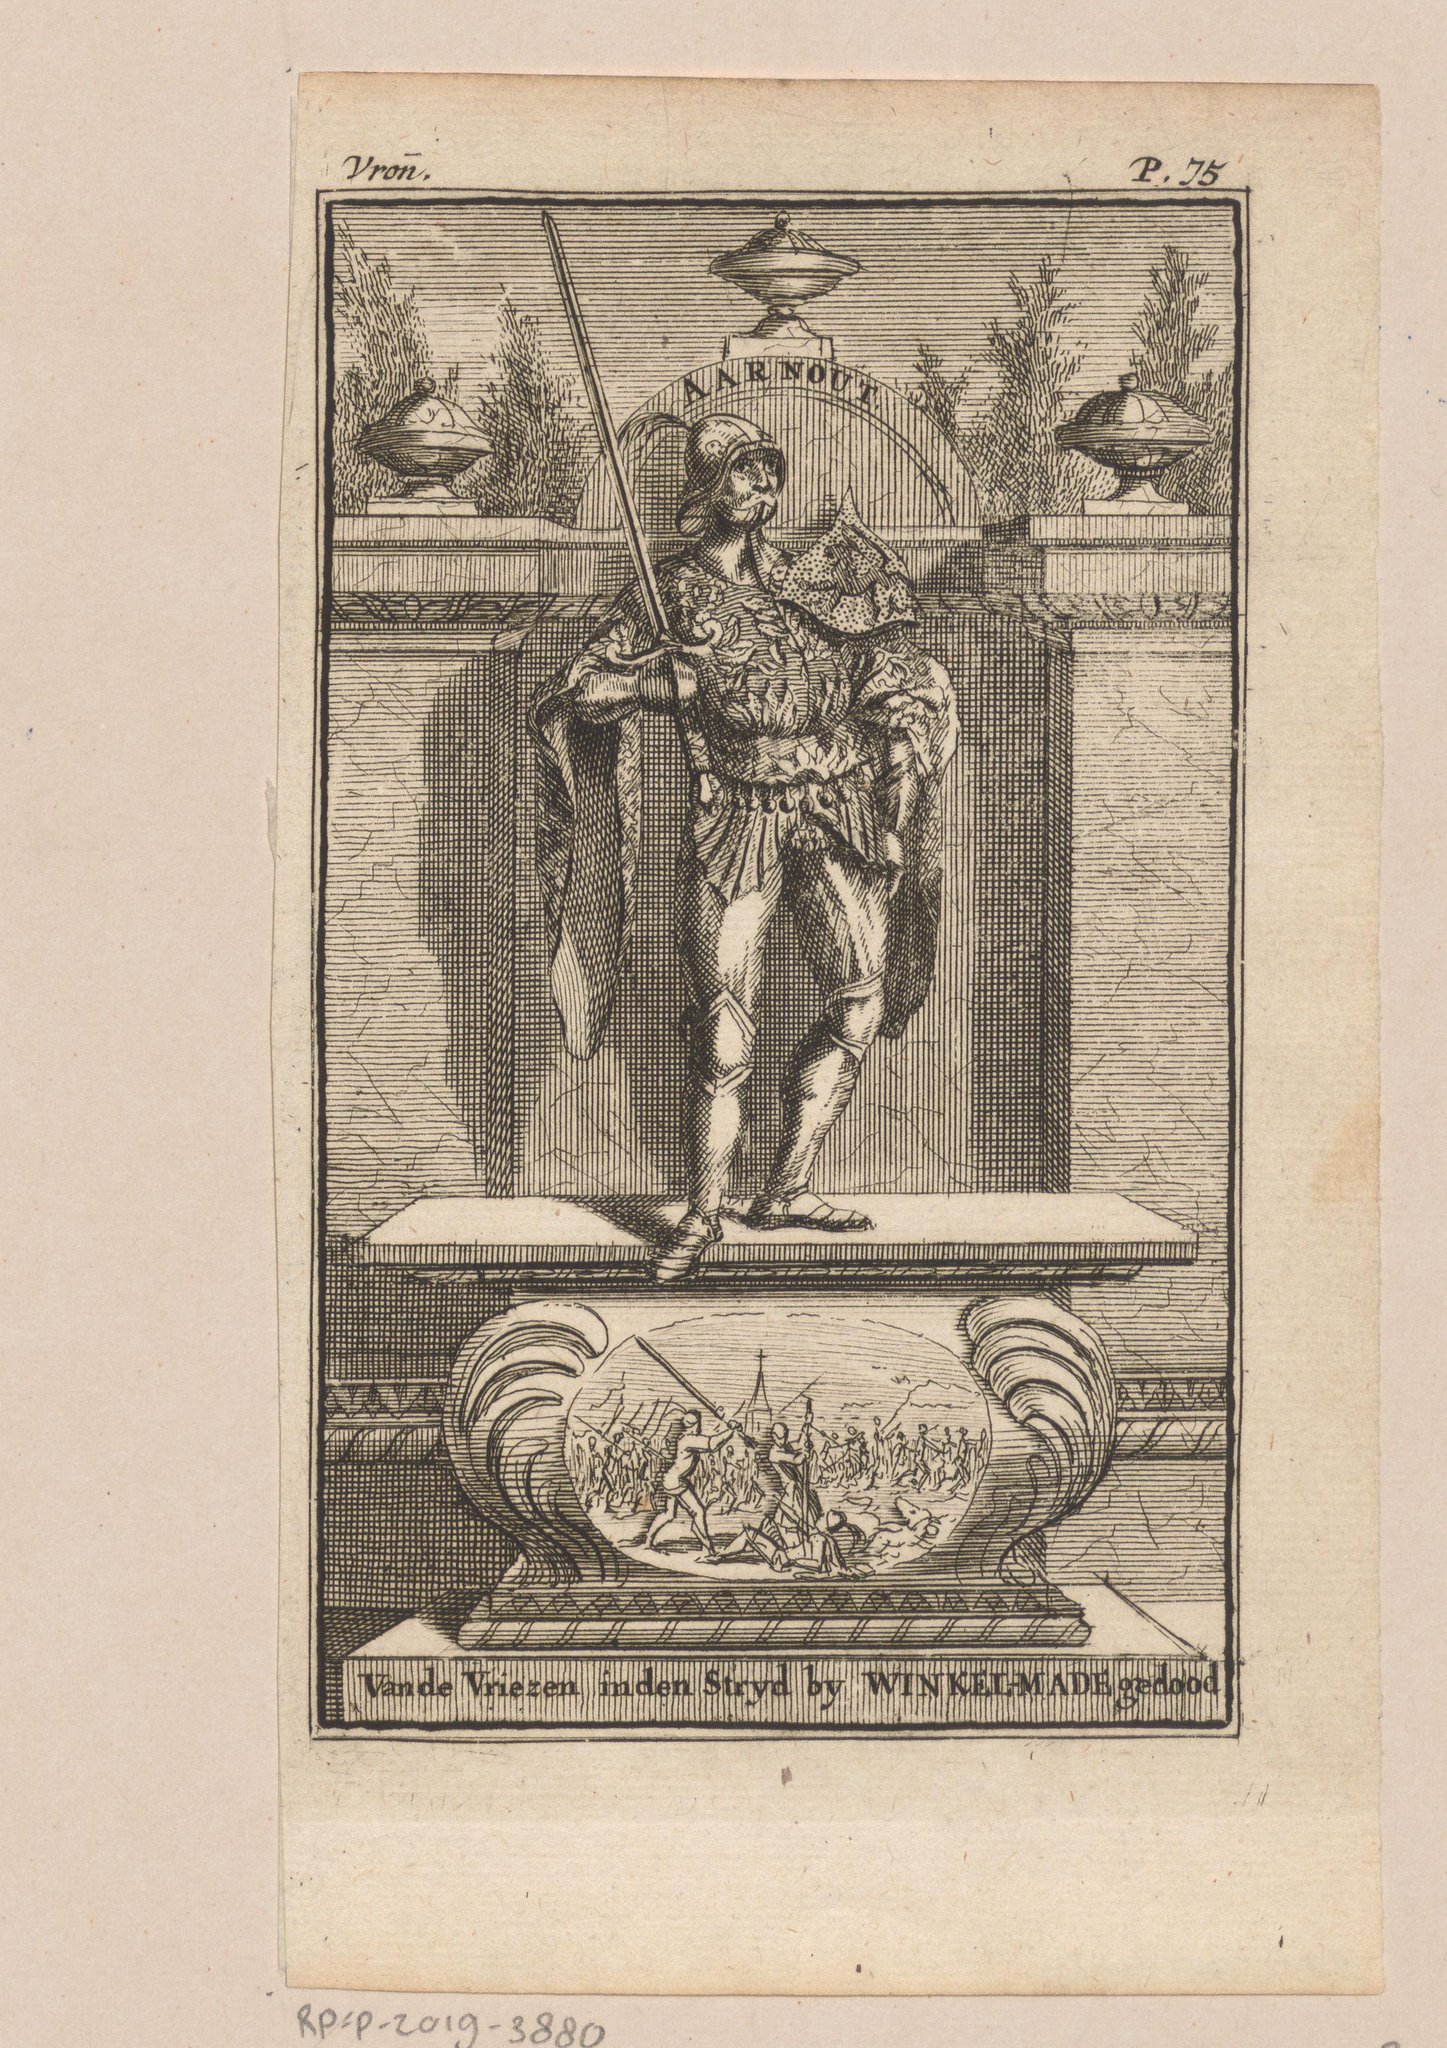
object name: print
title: Portret van Arnulf, graaf van Holland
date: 1702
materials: paper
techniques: etching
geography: amsterdam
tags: ghent, earl, armour, historical persons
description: Prent uit: Soeteboom, Hendrik Jacobsz. Oud-heden van Zaan-land, Stavoren, Vronen en Waterland. Amsterdam: Willem Linnig van Koppenol, 1702, dl. 2, p. 75.